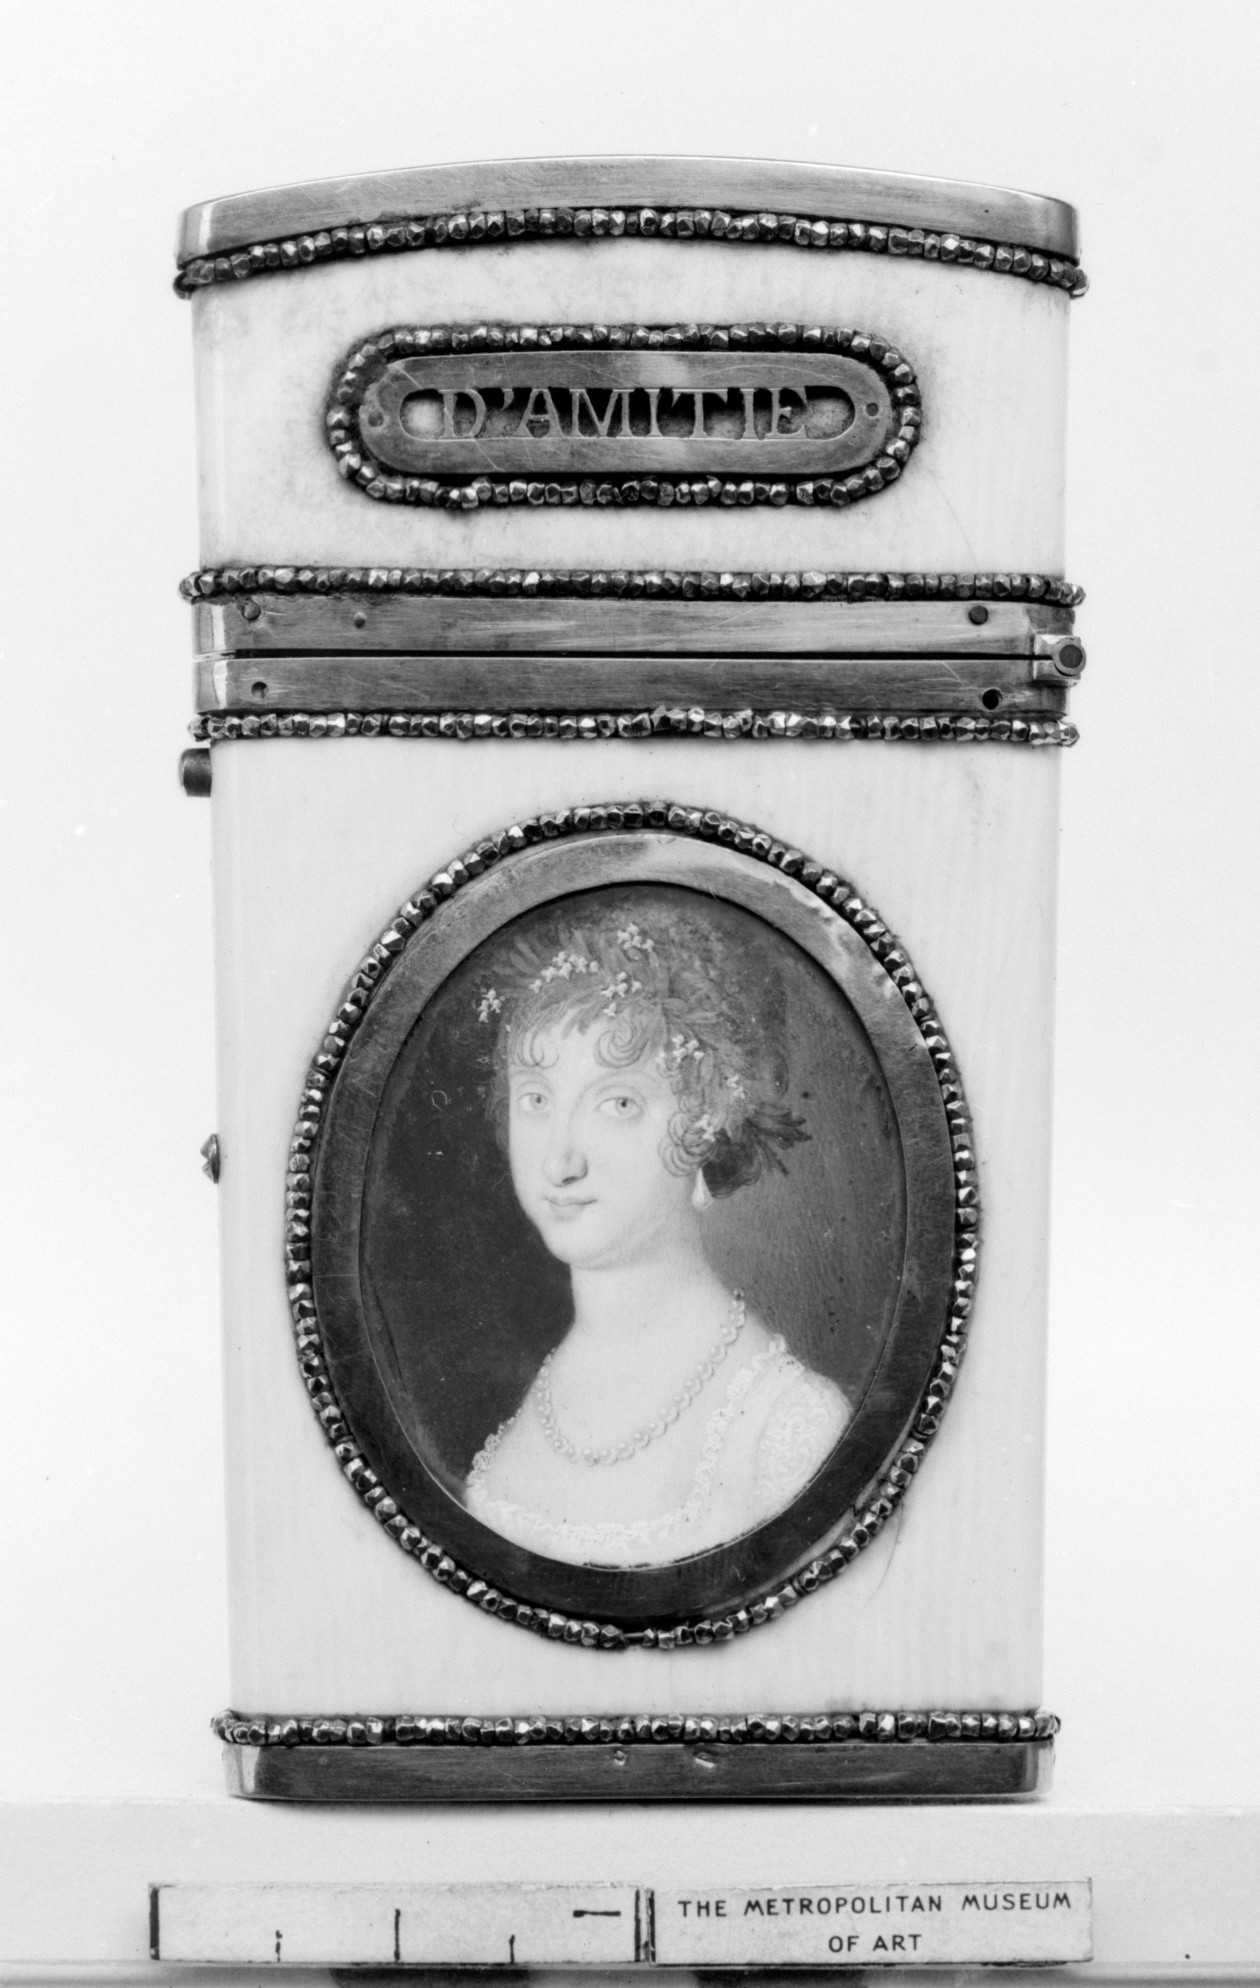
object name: souvenir, painting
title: Souvenir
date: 1701-1800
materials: gold, ivory, steel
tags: portraits,women